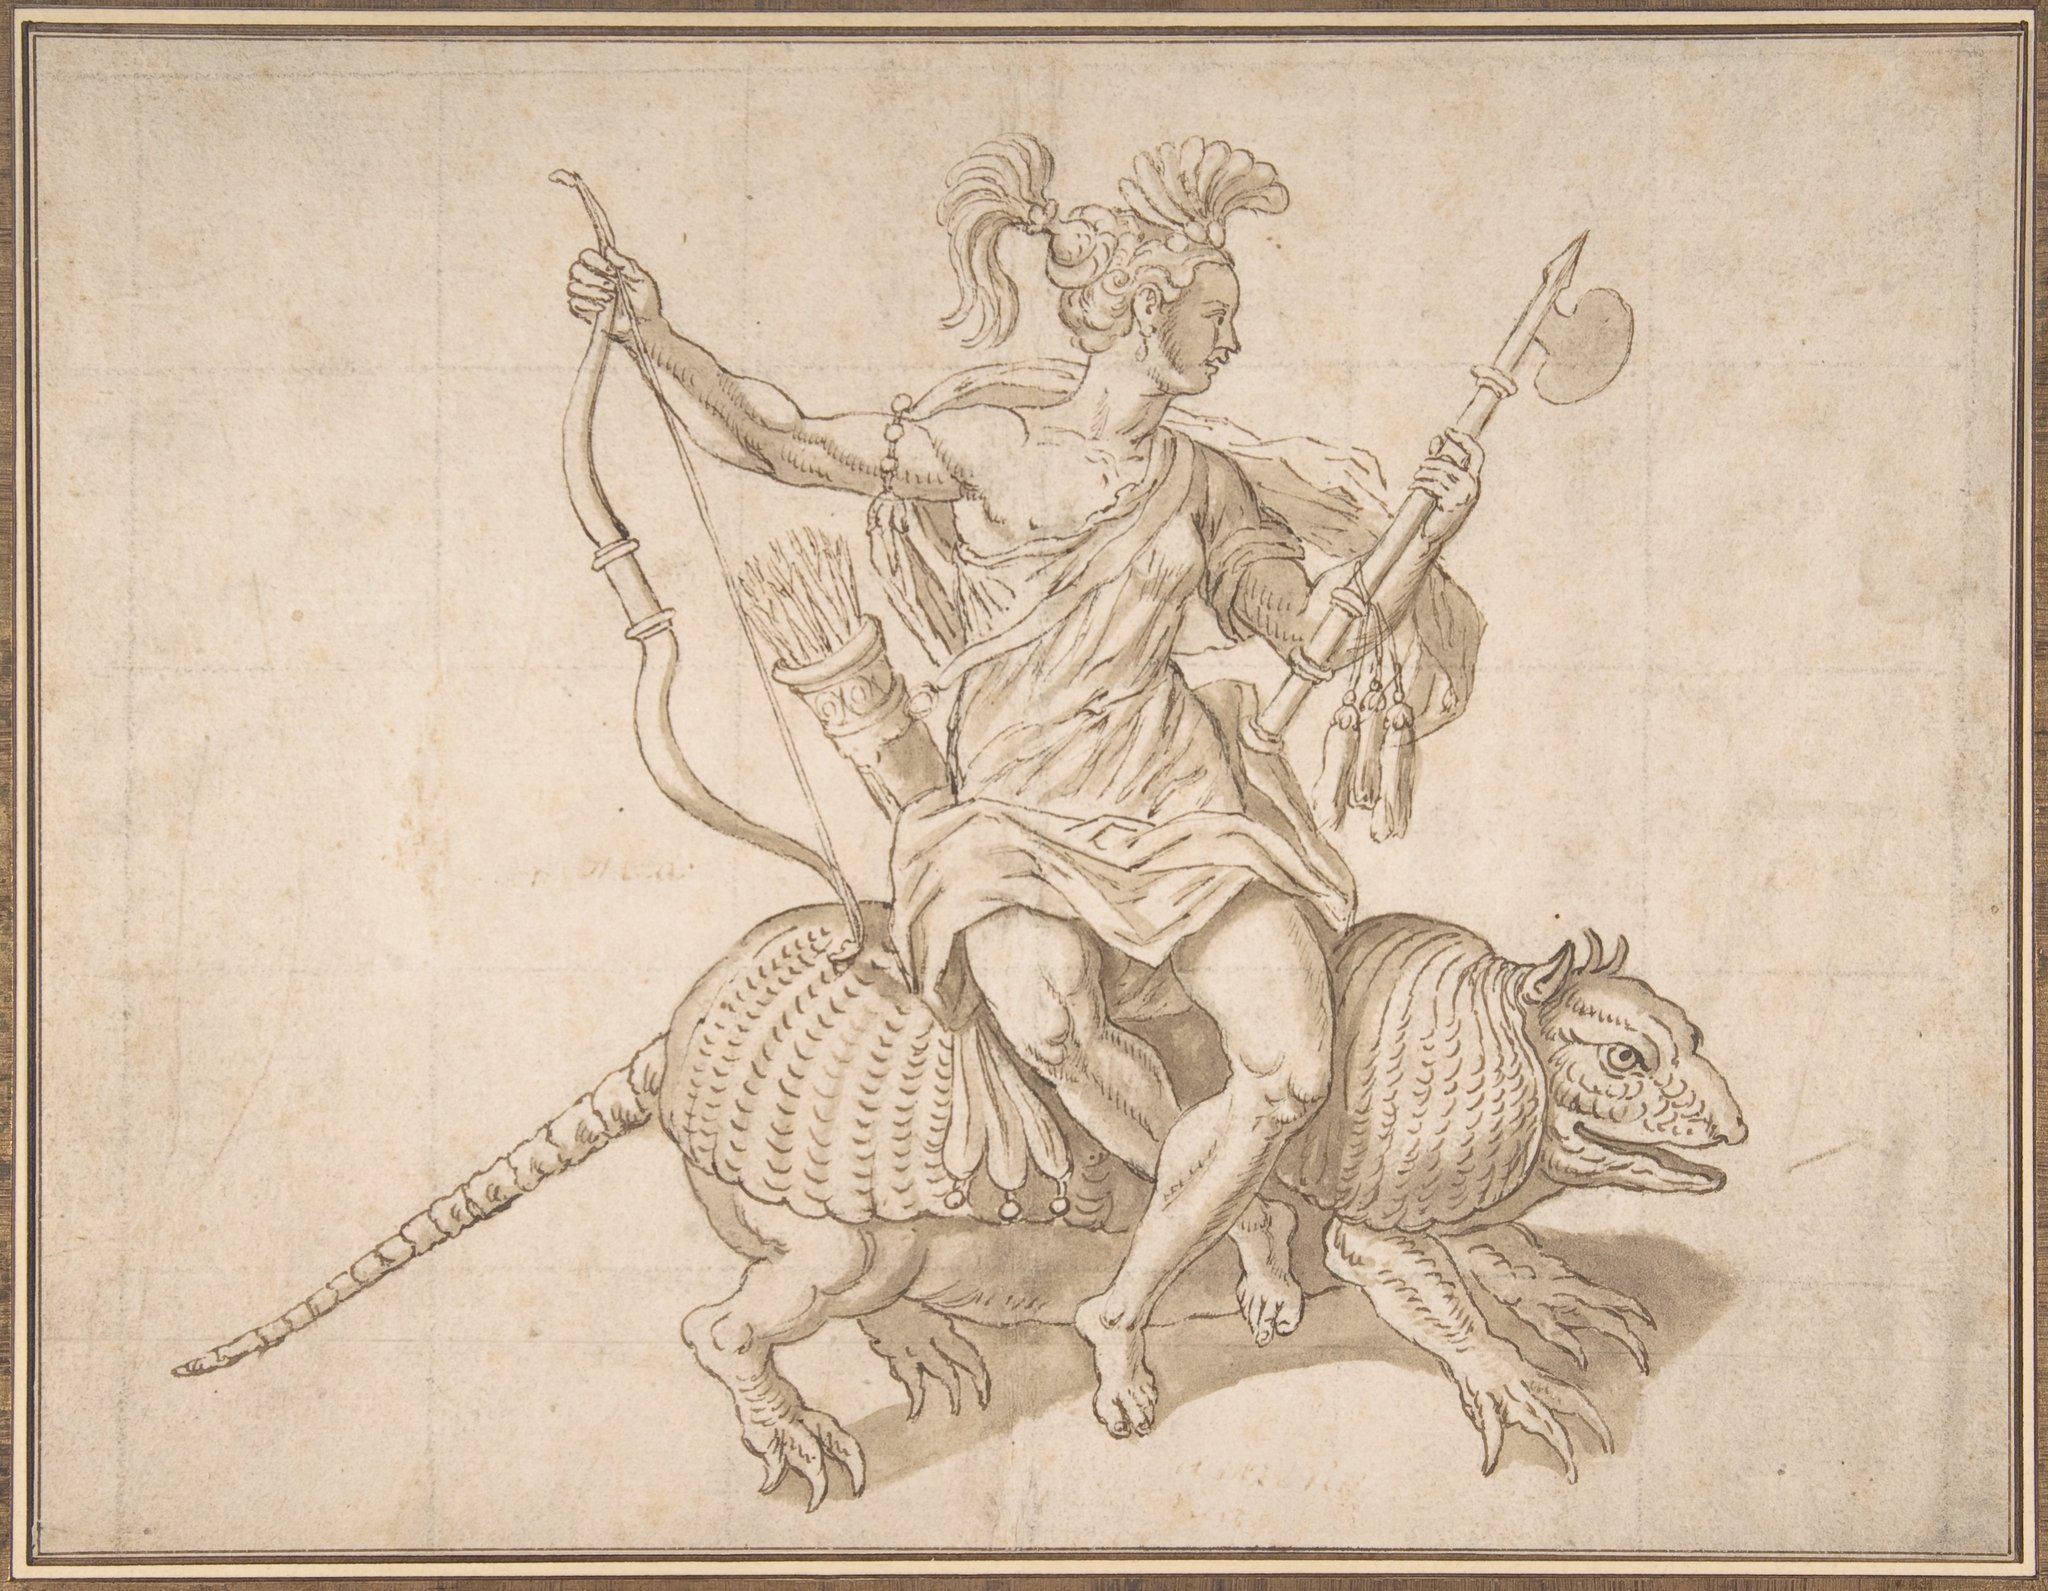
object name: drawing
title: Allegory of America, from "The Four Continents"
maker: anonymous, netherlandish, 16th century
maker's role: artist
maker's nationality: netherlandish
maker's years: 1500-1600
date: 1501-1600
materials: chalk, ink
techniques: brush, pen, drawing, wash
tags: animals,bow and arrow,women,axes